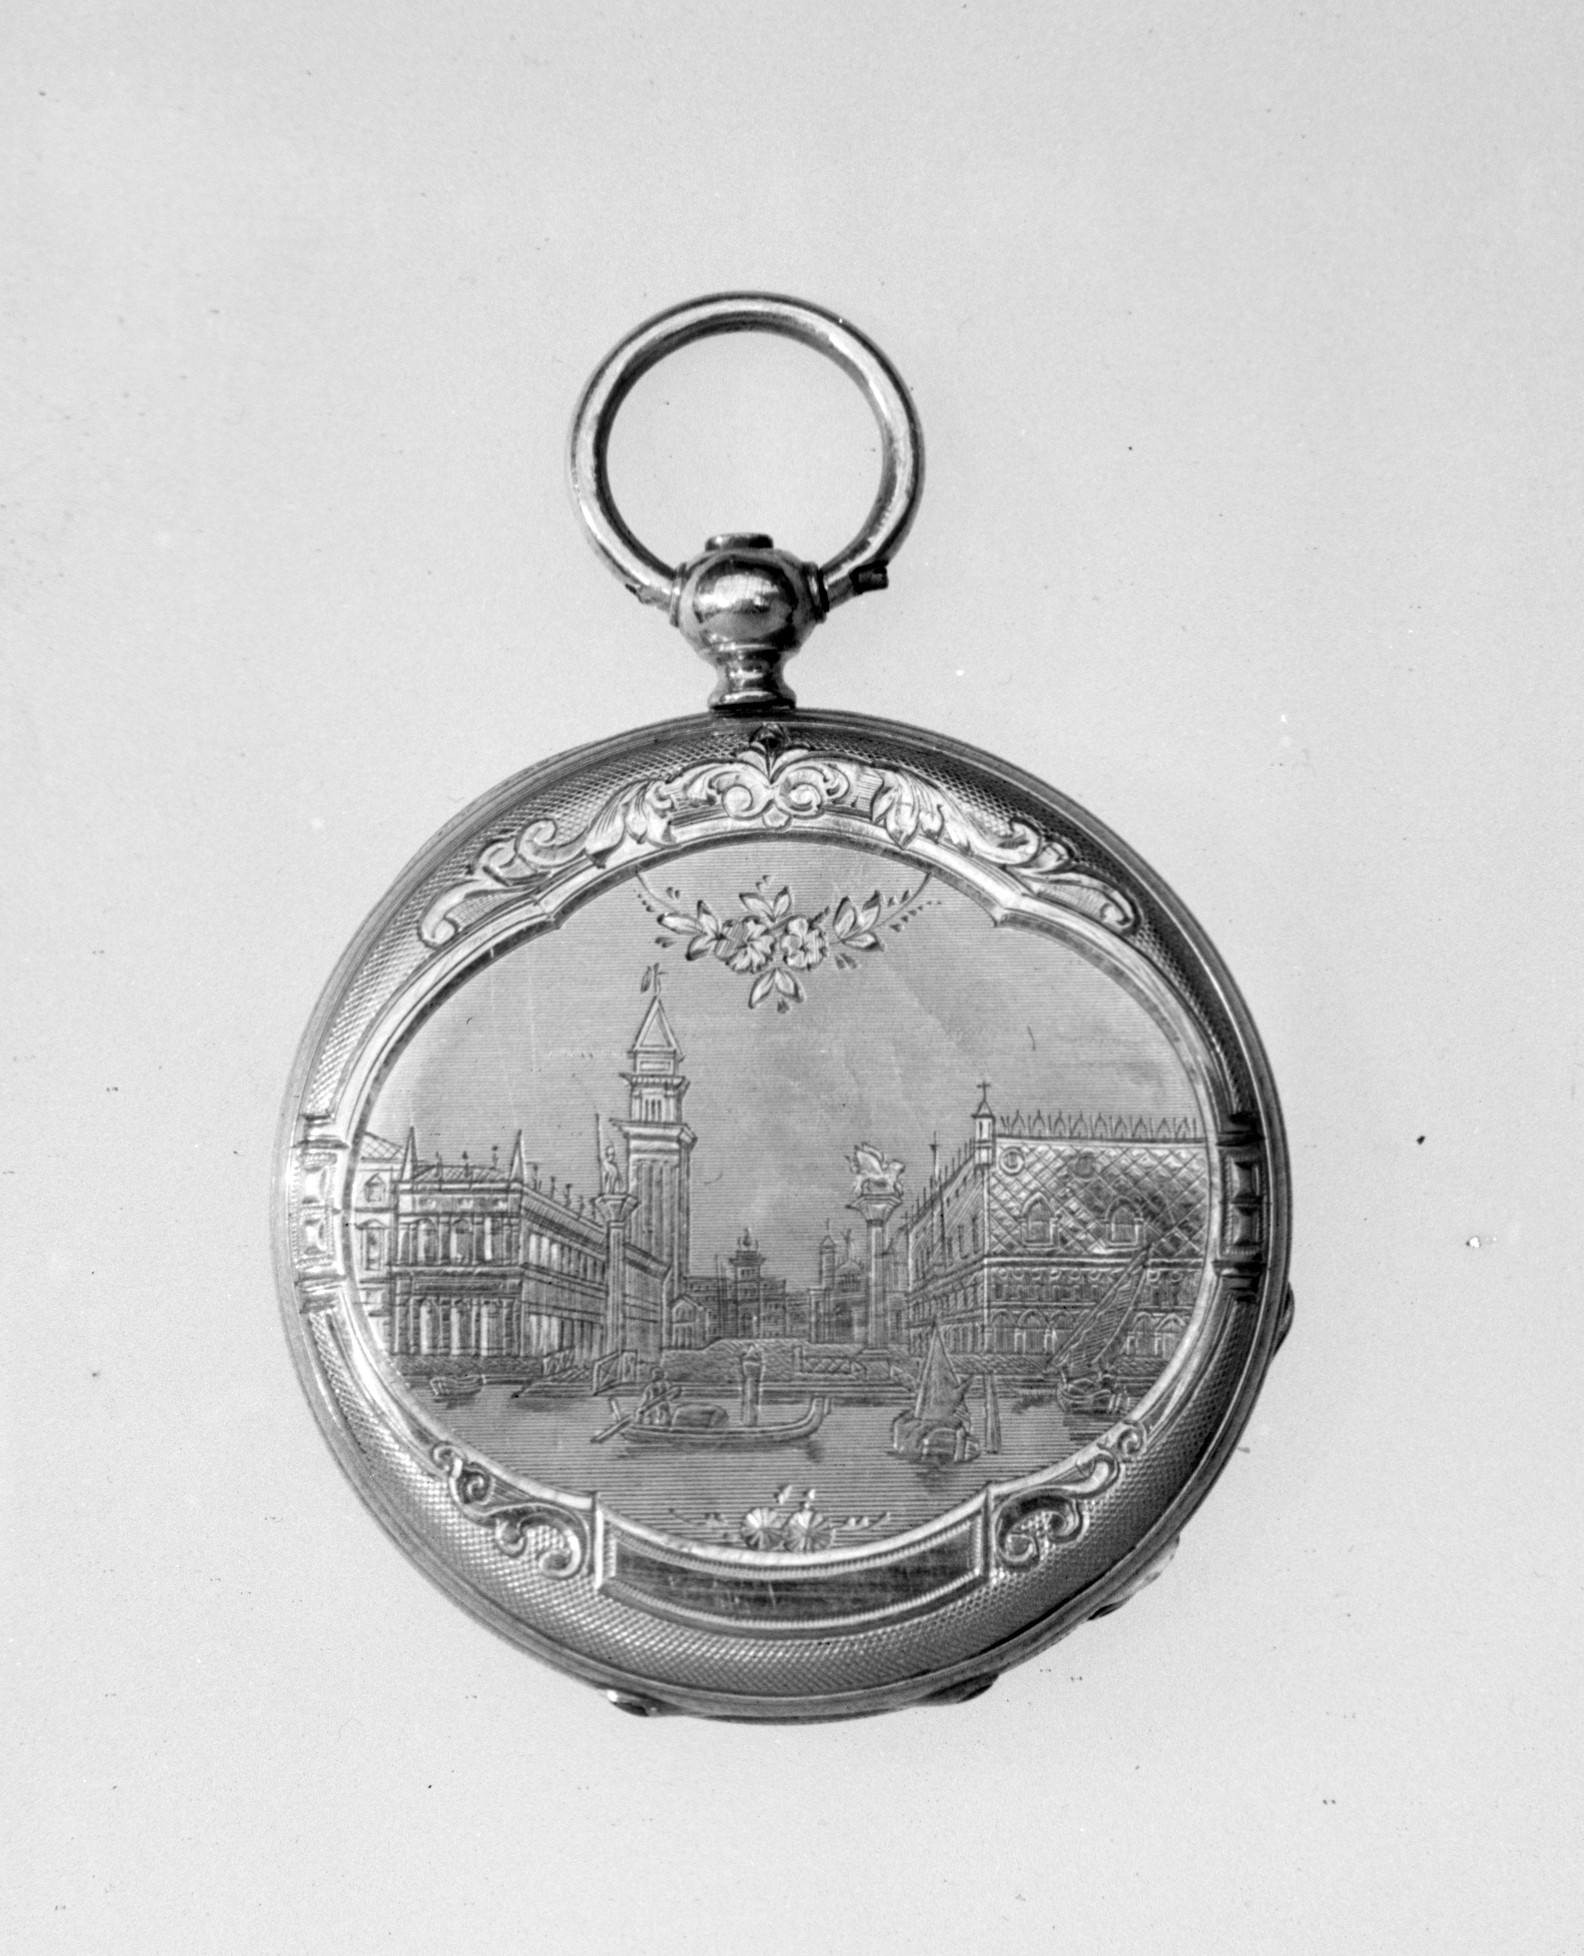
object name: watch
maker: eugène bornand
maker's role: maker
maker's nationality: swiss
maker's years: 1830-1890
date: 1850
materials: enamel, gold, steel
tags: buildings,towers,boats,venice